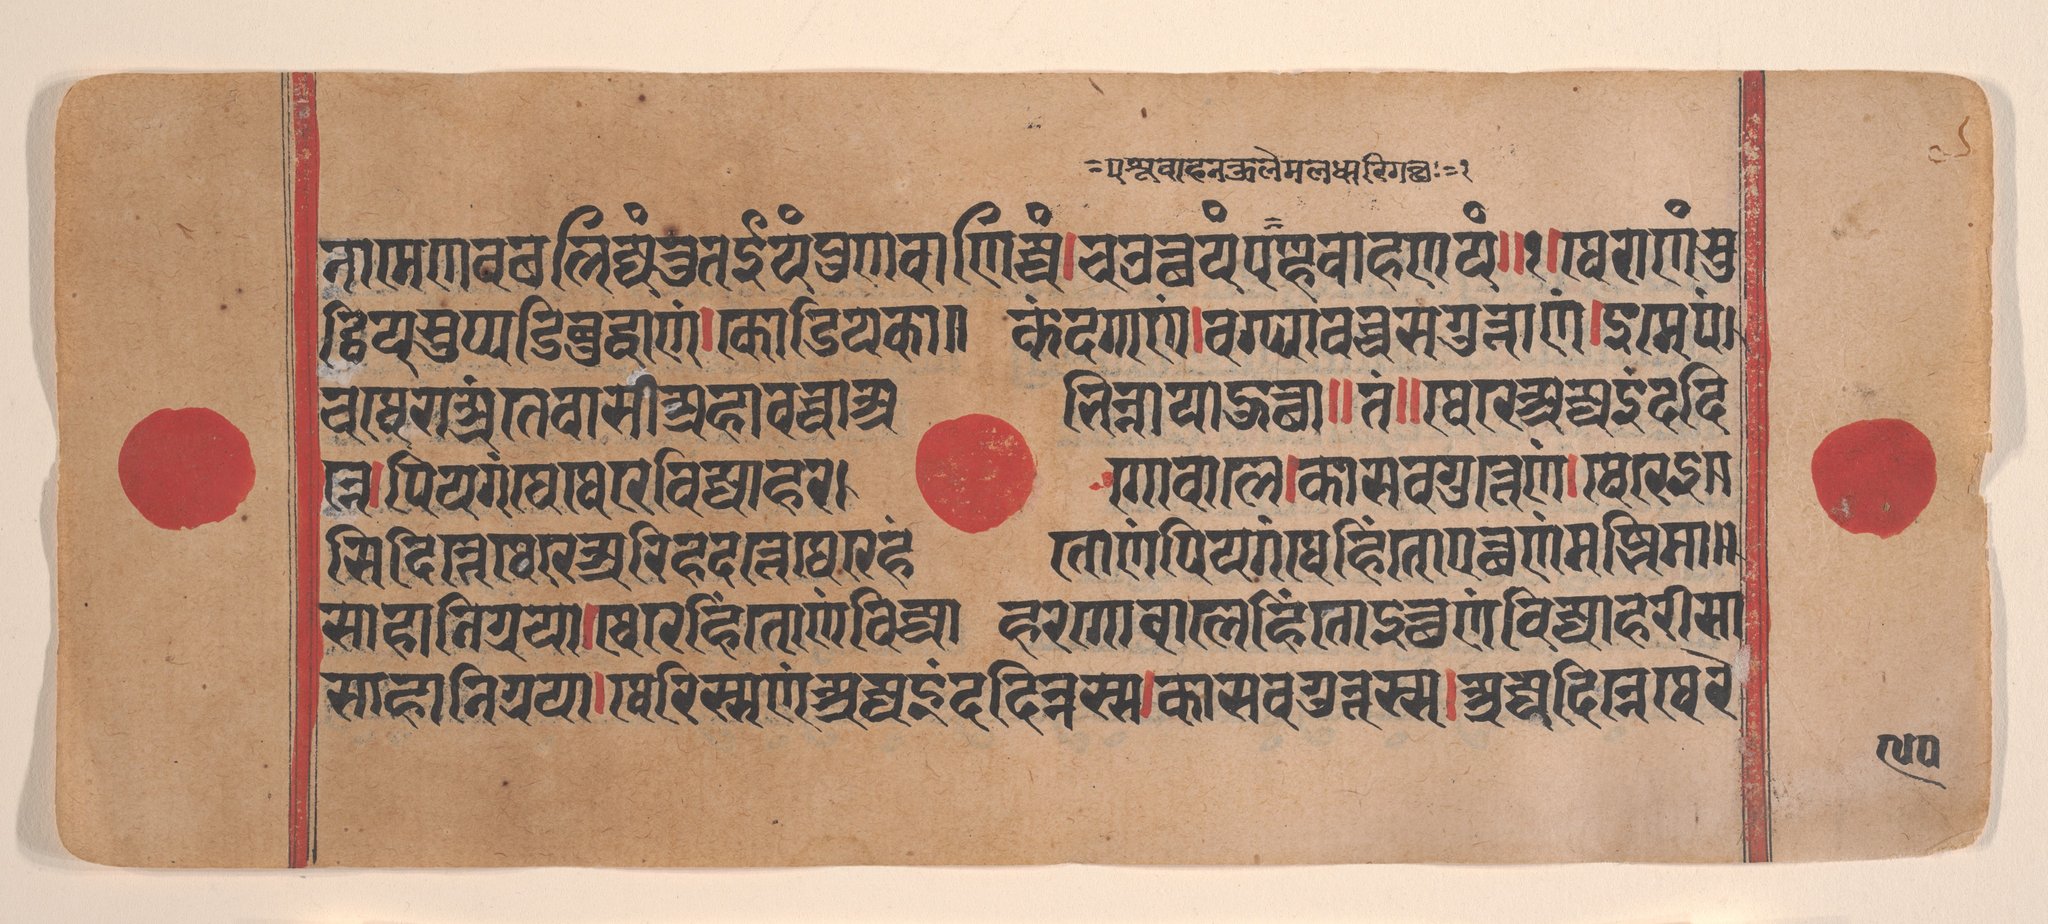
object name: folio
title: Page from a Dispersed Kalpa Sutra (Jain Book of Rituals)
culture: indian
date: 1401-1500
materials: gold, ink, paper, watercolor